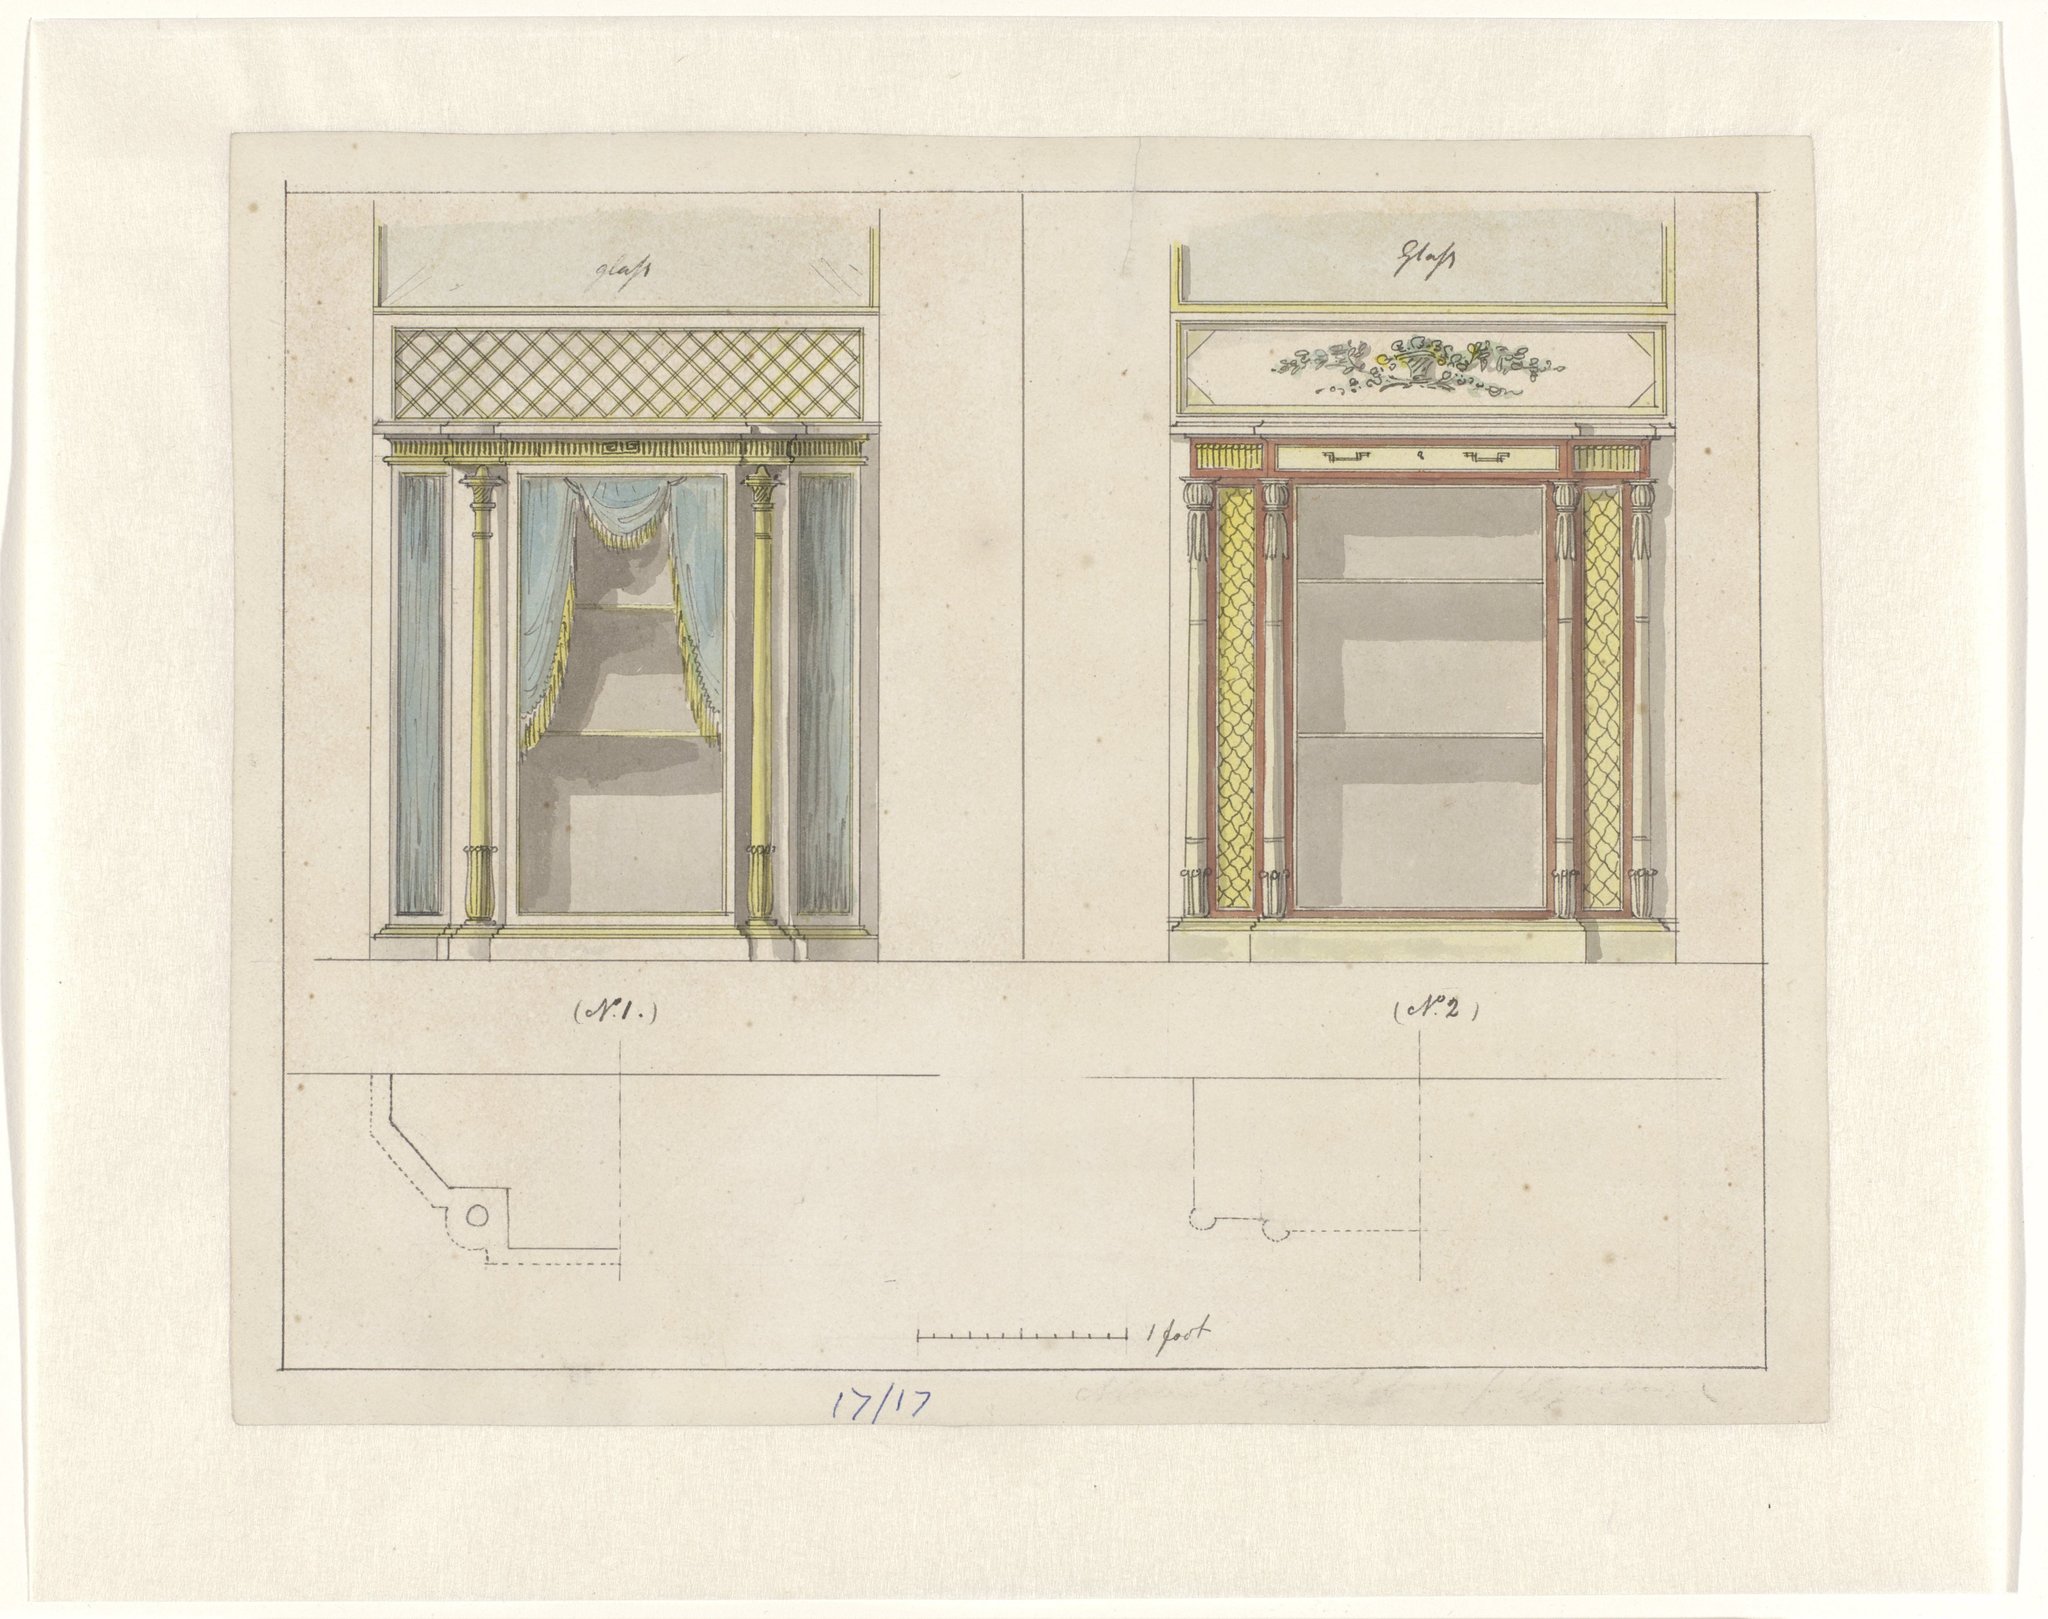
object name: watercolor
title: Ontwerp voor twee damcommodes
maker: charles heathcote tatham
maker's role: architect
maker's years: 1772-1842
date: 1795-1800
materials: ink, paper, watercolor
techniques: brush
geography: london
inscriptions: : Ontwerp voor twee damcommodes, met onder beide een doorsnede van de linkerhelft. Inscripties in zwarte inkt: glass, Glass, (No. 1.) en (No. 2). Midden onder schaalverdeling met '1 foot'. Latere inscriptie in blauwe inkt: 17/17. Verso: inscripties in potlood: T. Hans [?] S n R{?}/ M27. Watermerk: 1794 / J WHATMAN.